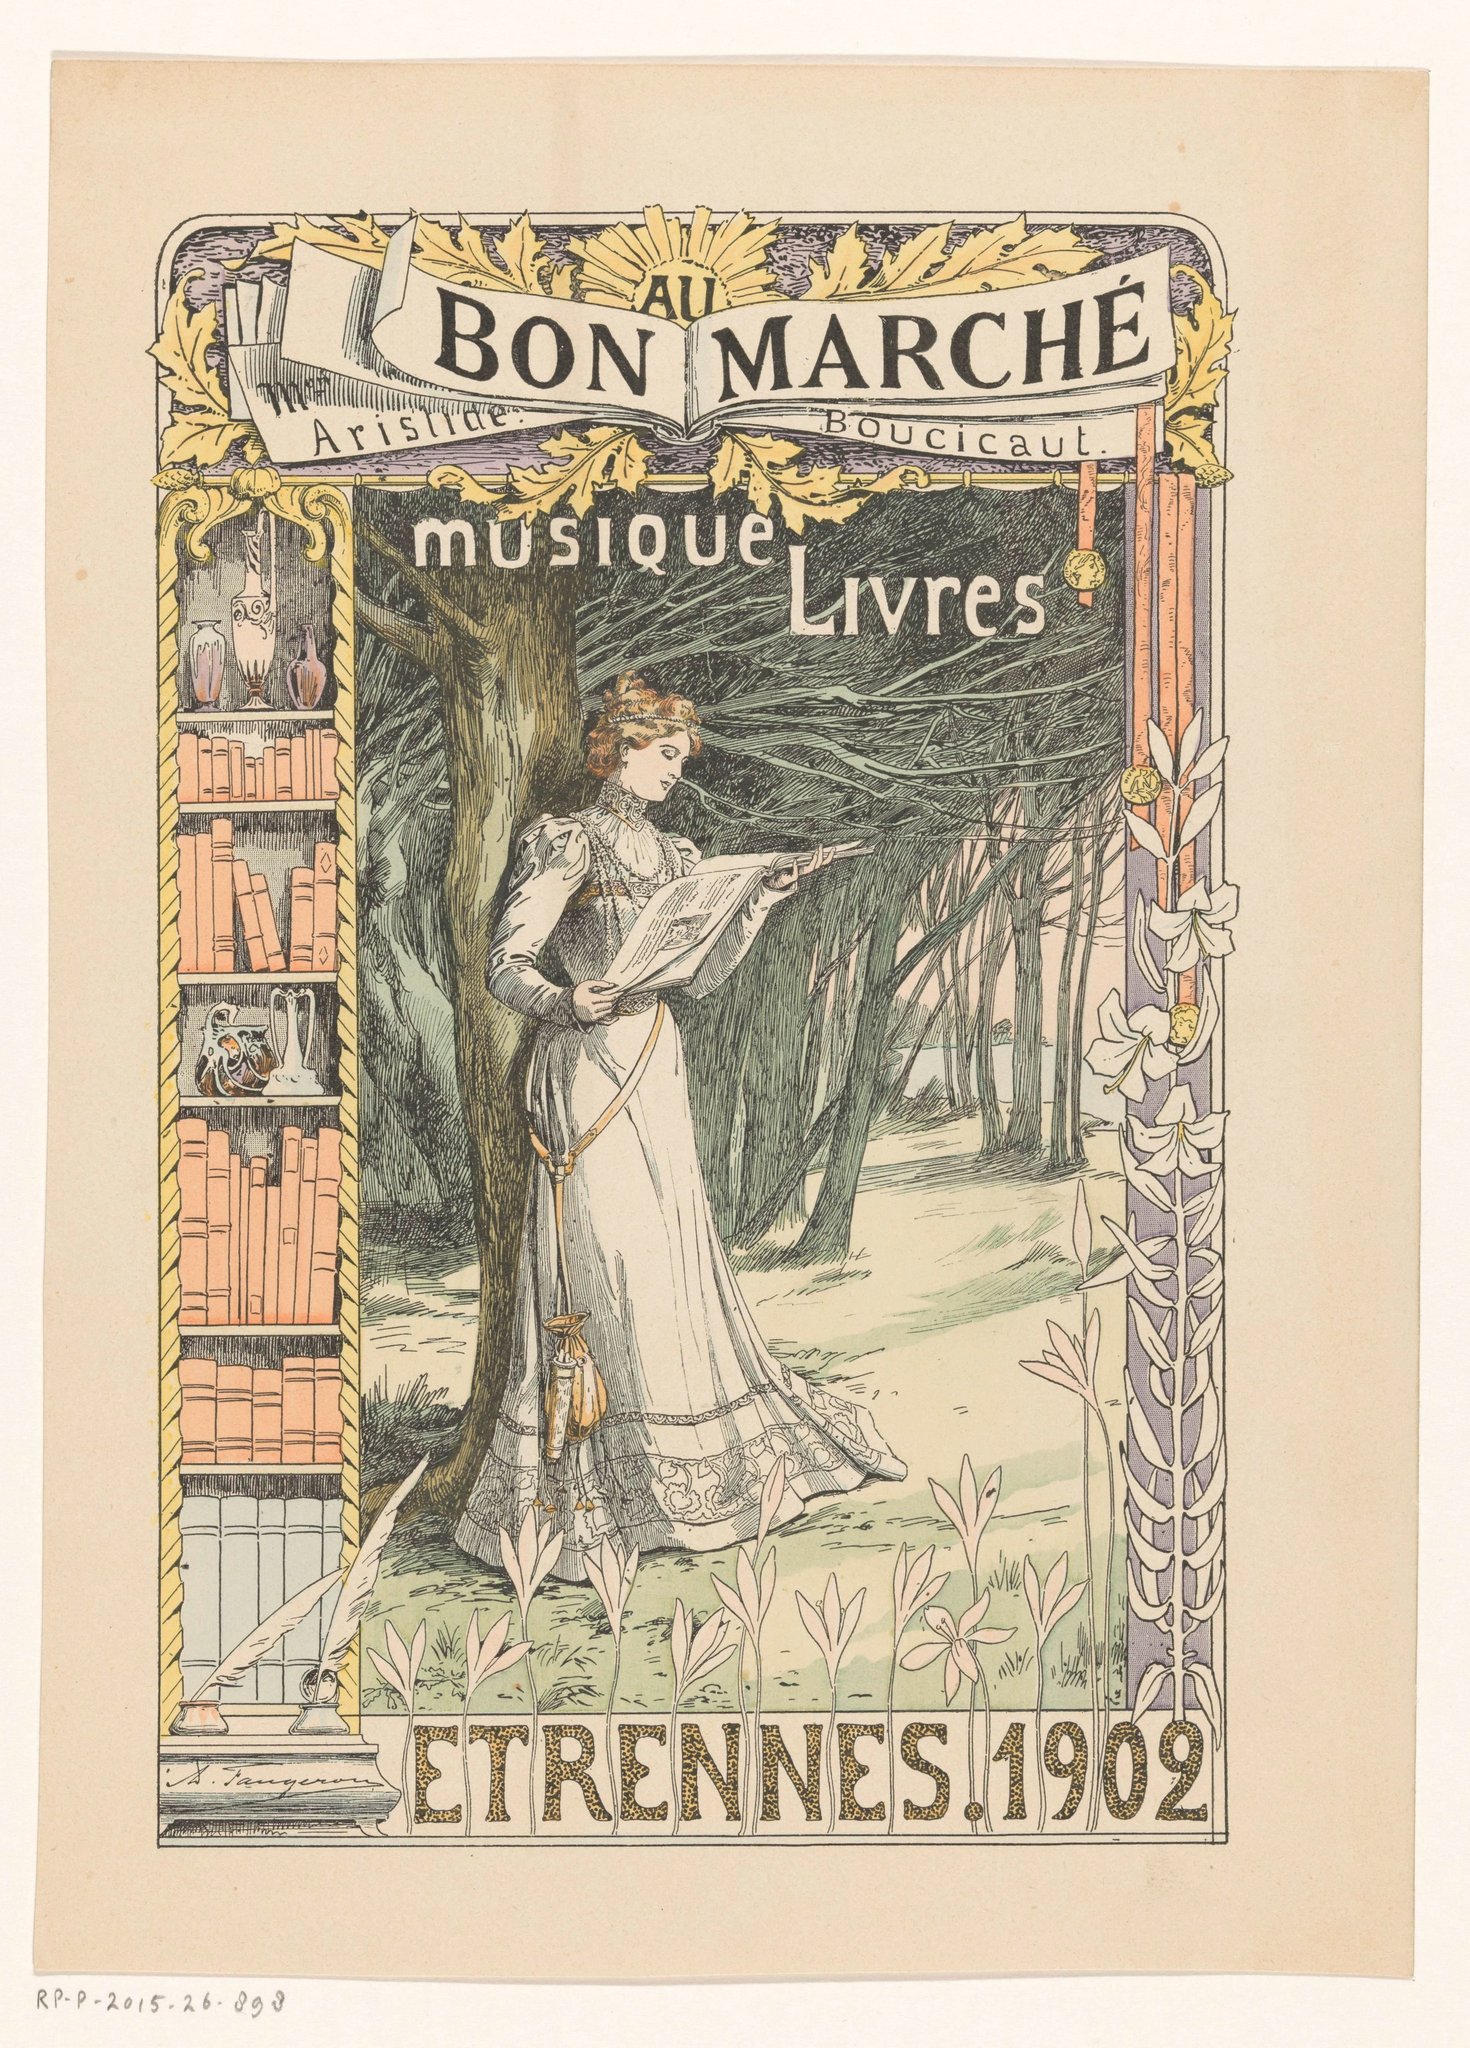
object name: print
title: Vrouw lezend in een tijdschrift, staand onder een boom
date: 1902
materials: paper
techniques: hand coloring, lithograph, pochoir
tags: bookshelves, newspaper, news-sheet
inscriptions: collector's mark: Lugt 4780, collector's mark: Lugt 2228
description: In omlijsting met rechts bloemen en links een kast met boeken en vazen, onderin een schrijfstel.